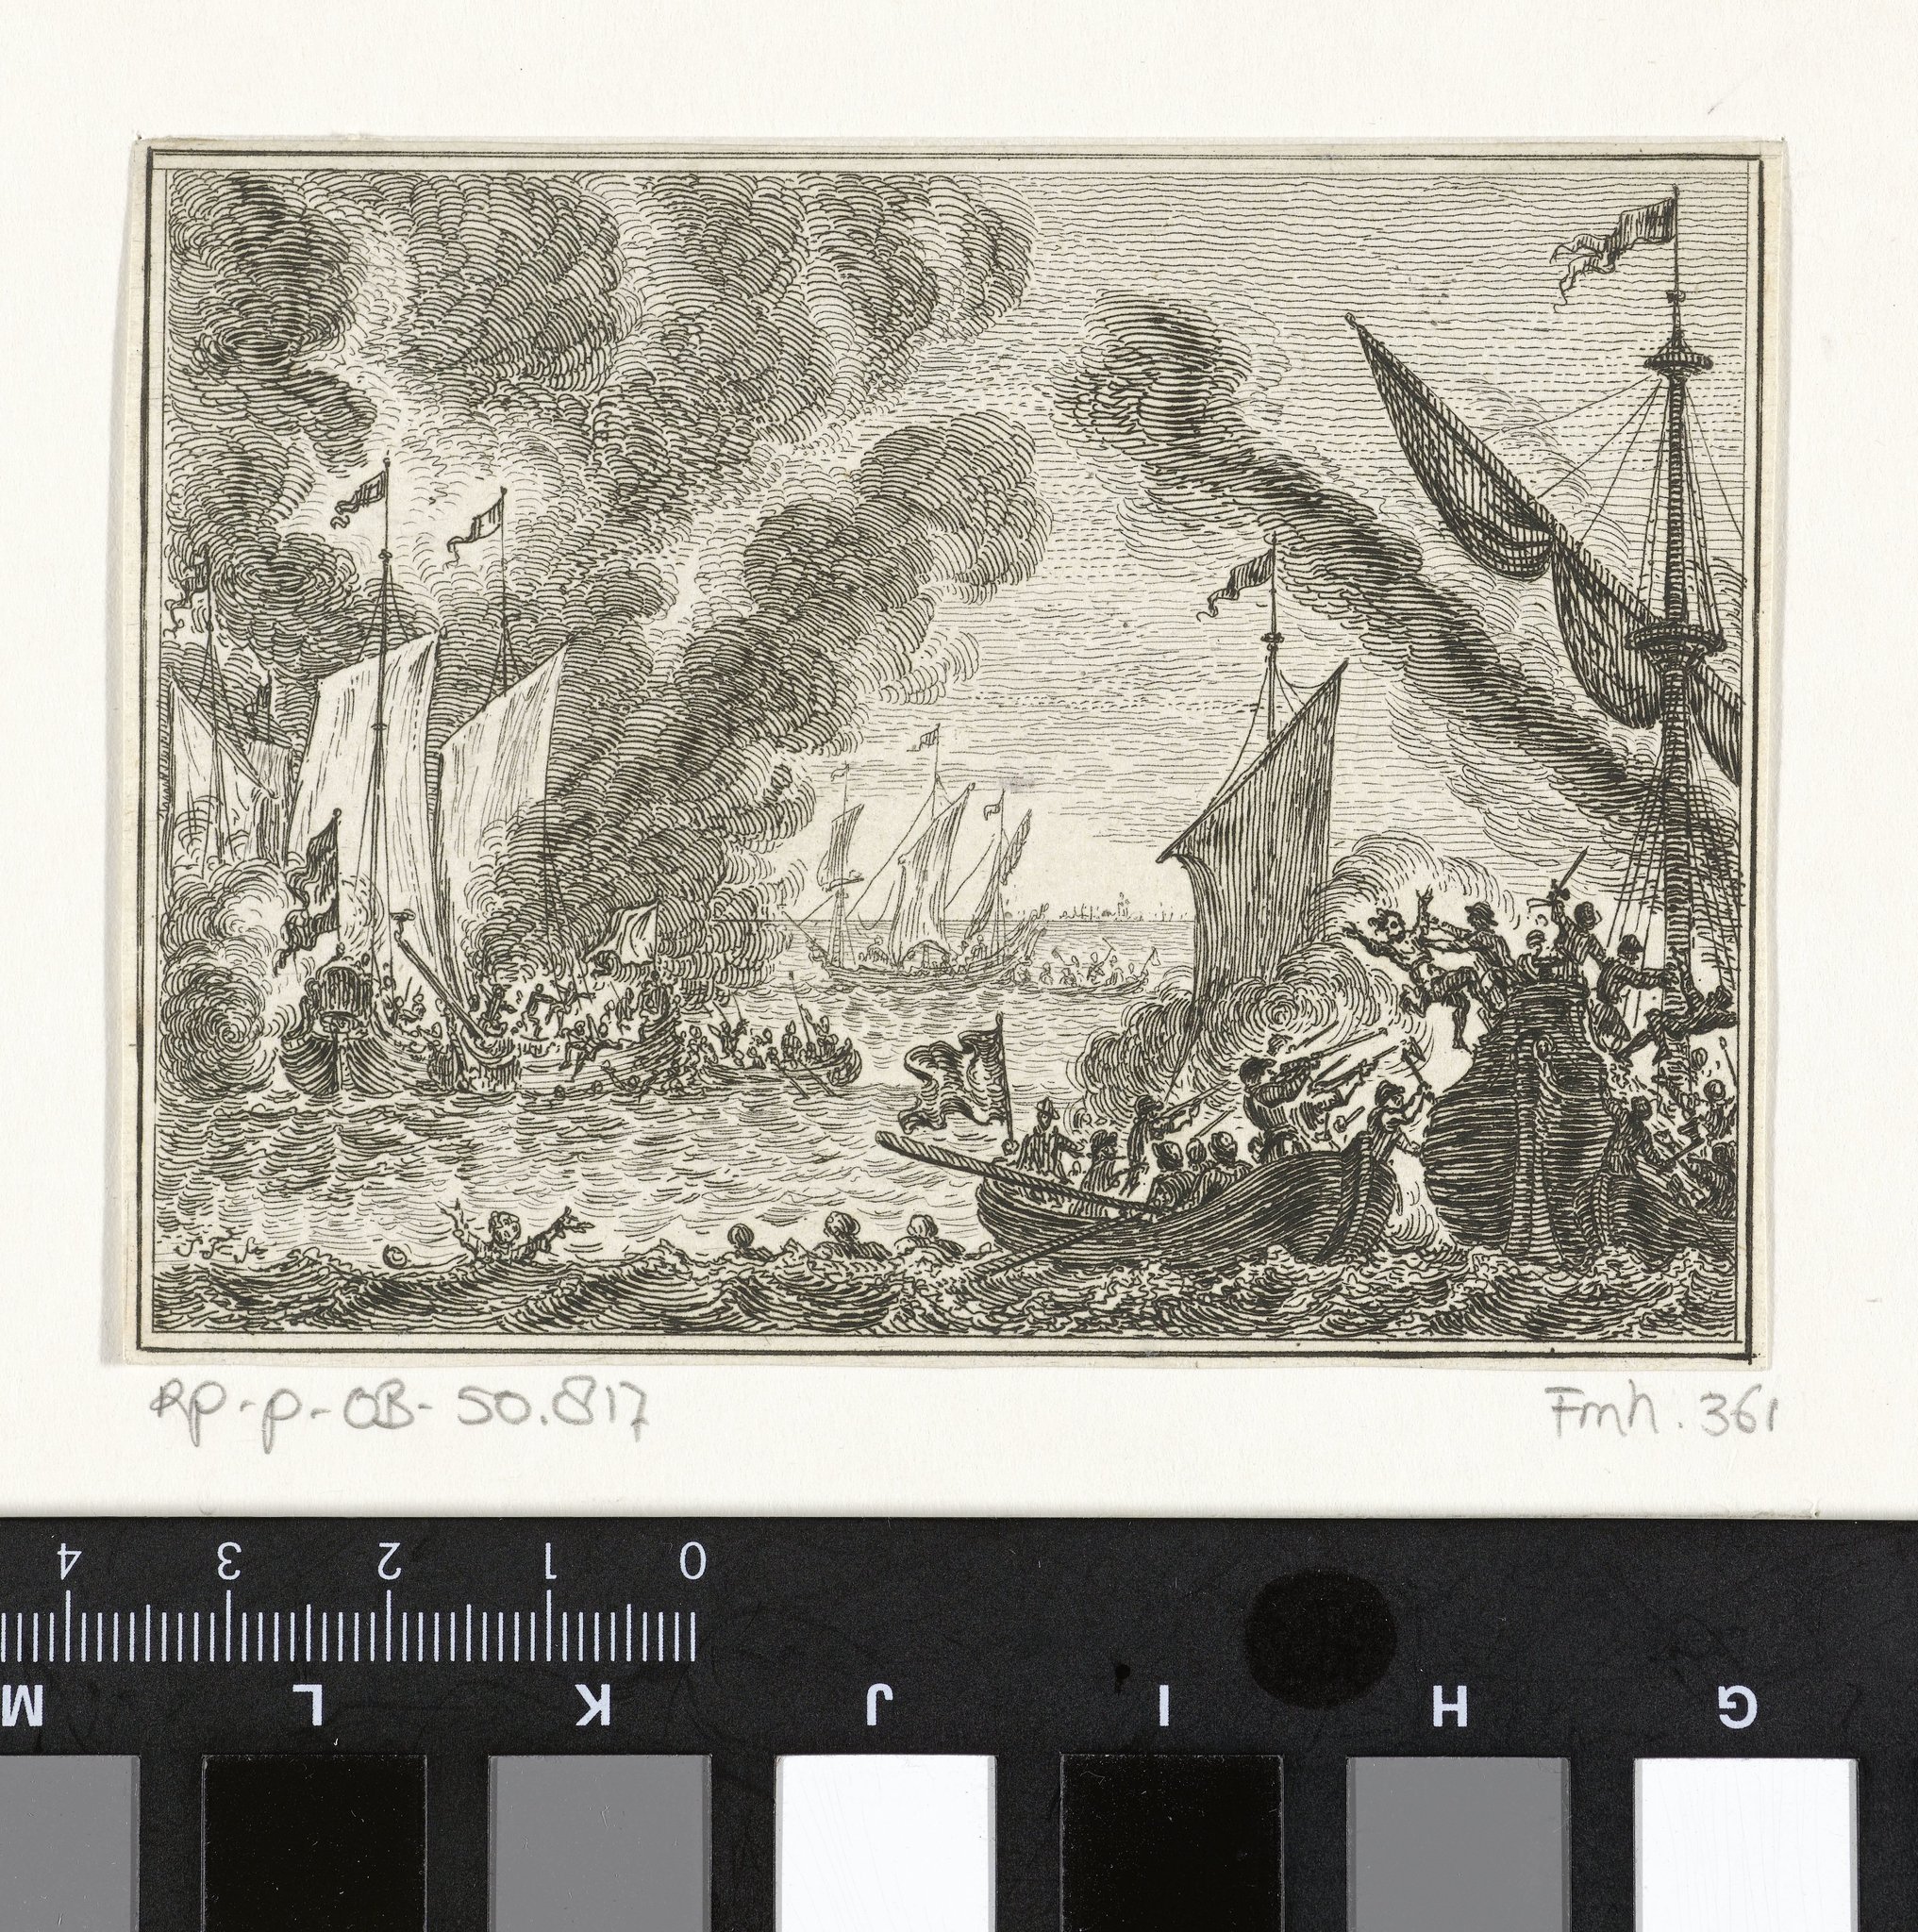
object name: print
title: Illustraties vaderlandse geschiedenis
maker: simon fokke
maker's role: draughtsman, print maker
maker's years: 1712-1784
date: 1784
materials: paper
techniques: etching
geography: amsterdam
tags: piracy, zuiderzee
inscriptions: collector's mark: Lugt 240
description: Voorstelling uit de vaderlandse geschiedenis. Grote Pier maakt met zijn piraterij de Zuiderzee onveilig. Overvallen en plunderen van schepen op het water onder leiding van de piraat Grote Pier.